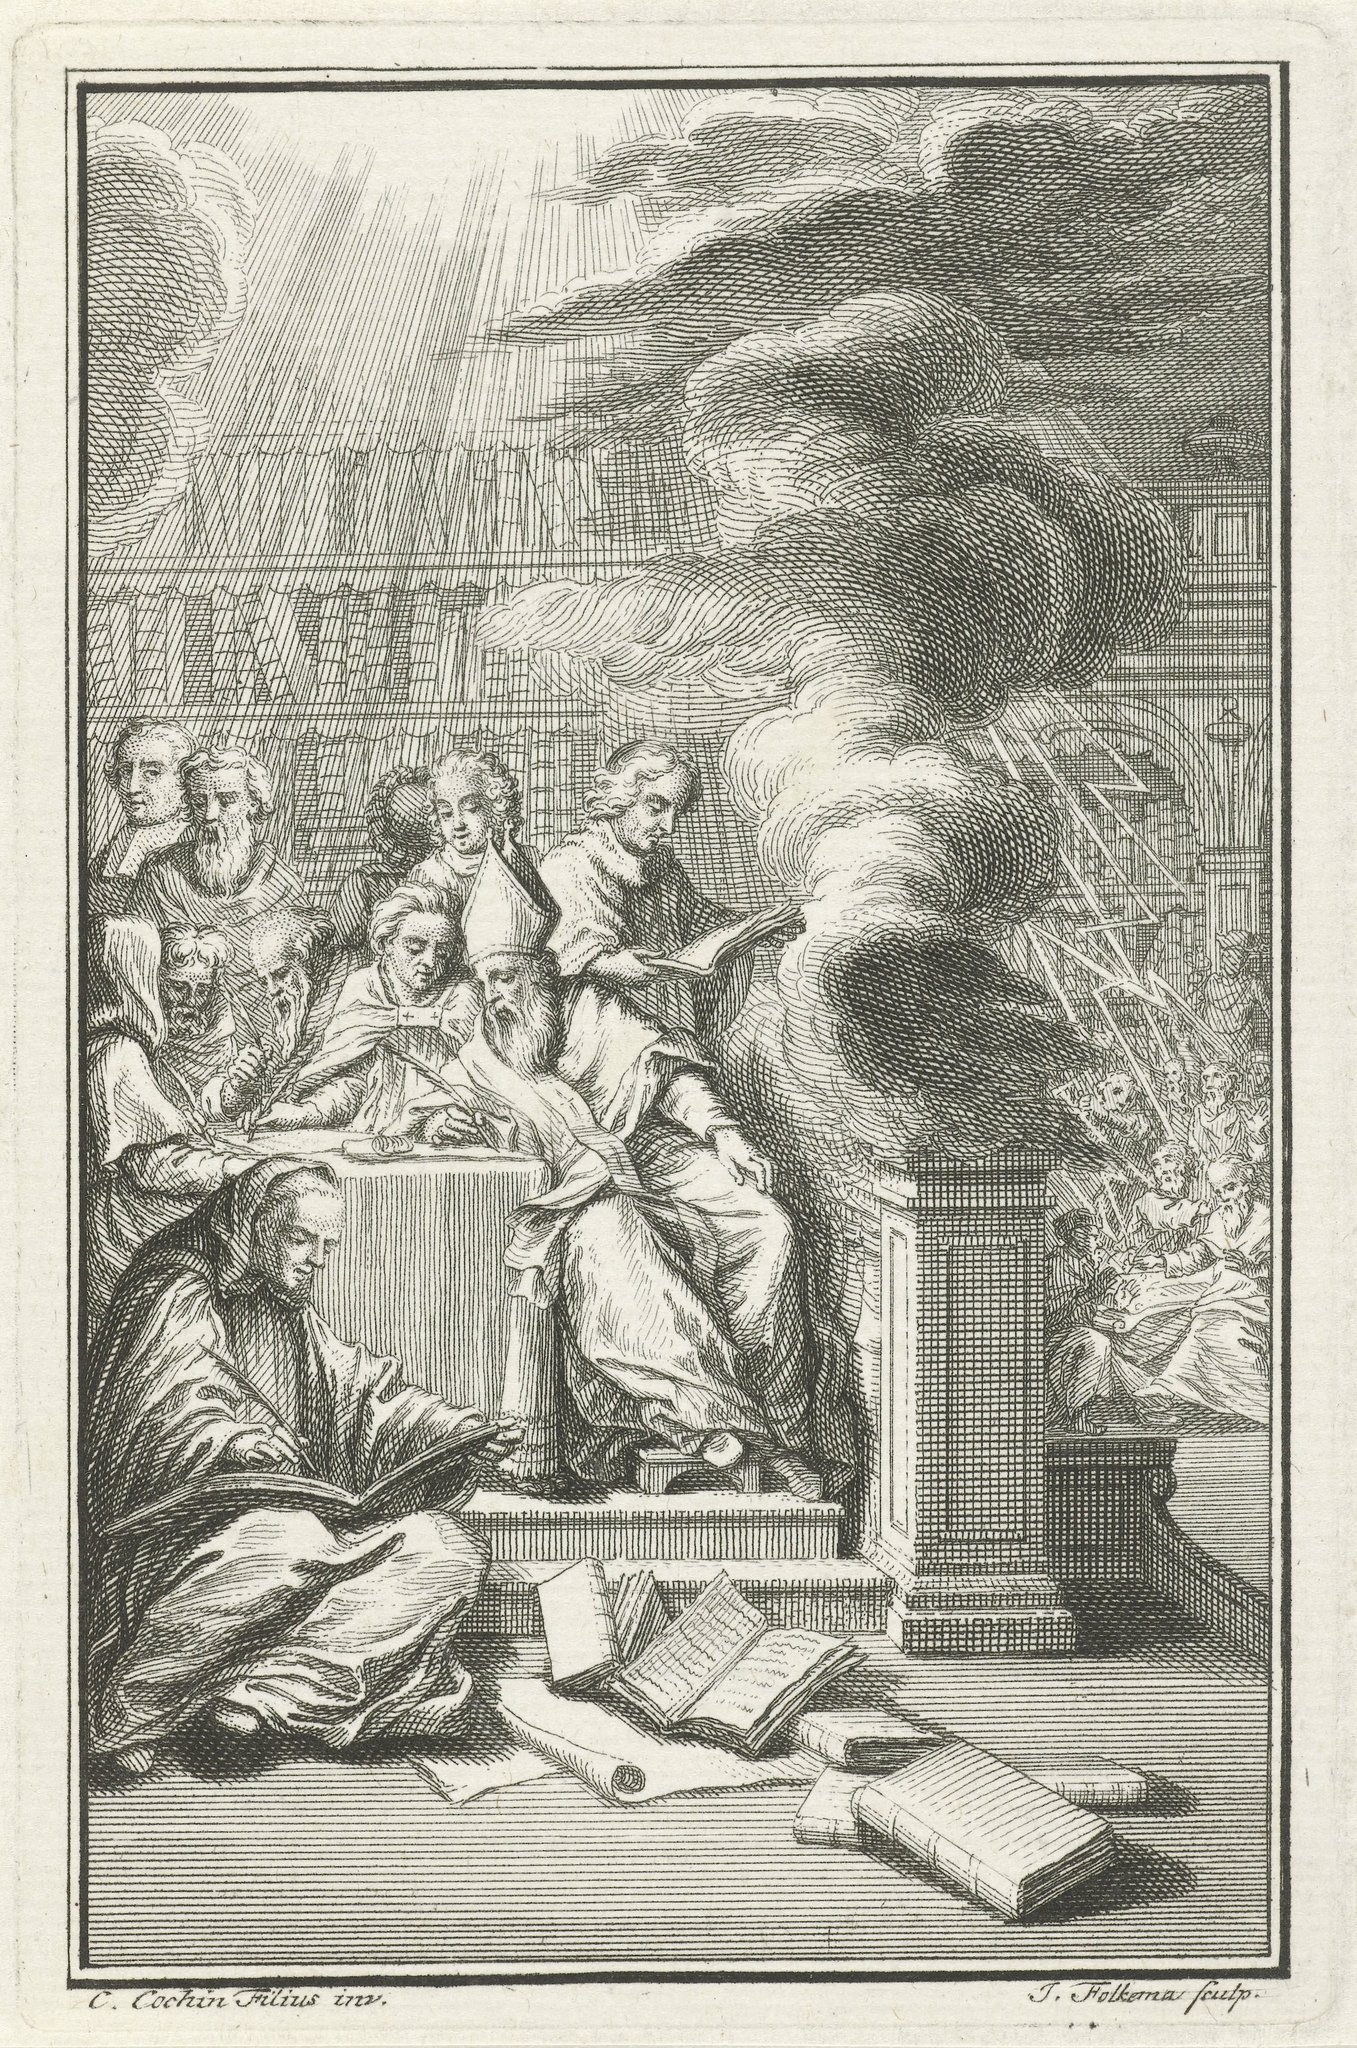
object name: print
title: Bijeenkomst van geestelijken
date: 1725-1767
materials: paper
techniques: etching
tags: lightning, flash of lightning, thunderbolt, organization, functionaries and dignitaries in roman catholic church; clergy in general, light shining out of the heavens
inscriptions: collector's mark: Lugt 240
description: Rond een tafel zitten geestelijken, beschenen door een bundel hemels licht, druk te schrijven. Rechts van deze door wolken afgeschermde ruimte zit een tweede groep schrijvende geestelijken. Angstig kijken ze naar de met bliksemschichten gevulde lucht boven hen.